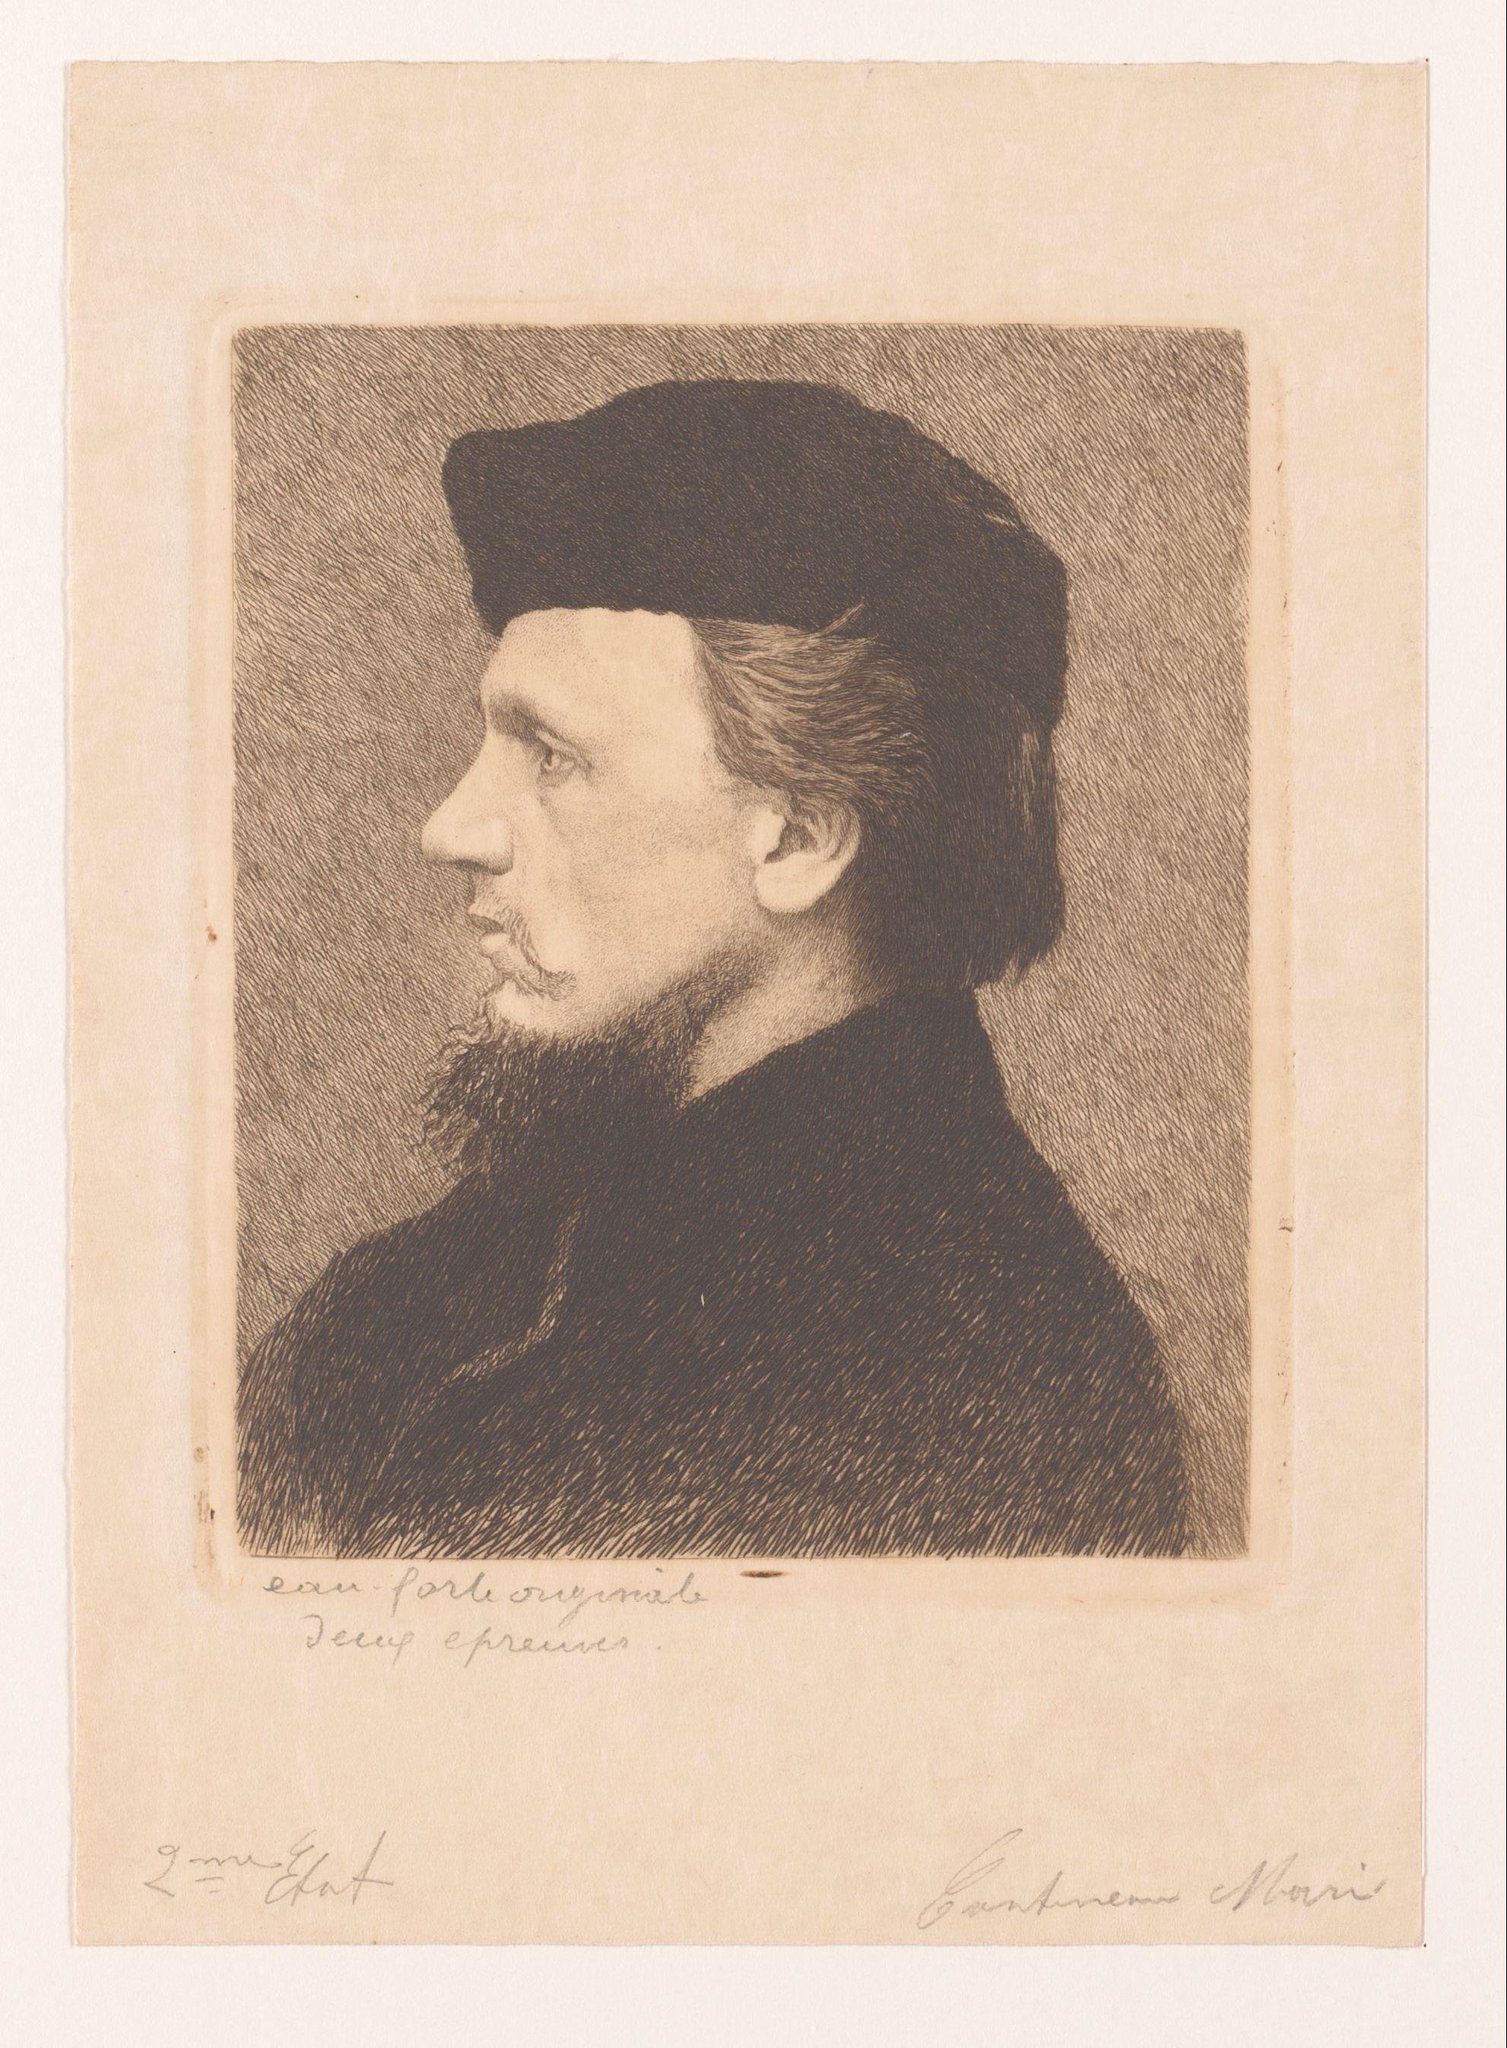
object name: print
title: En profil portret van Hugo de Groot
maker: mary hector rupert cantineau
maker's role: draughtsman, print maker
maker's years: 1875-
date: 1885-1909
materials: paper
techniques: drypoint, etching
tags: delft, hugo de groot, historical person (...) - historical person (...) portrayed alone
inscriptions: annotation: ‘2me état’, annotation: ‘eau forte originale deux epreuves’, collector's mark: Lugt 2228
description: Sterfdatum prentmaker onbekend. Derhalve is voor bepaling van de rechten van dit object de verwervingsdatum aangehouden.